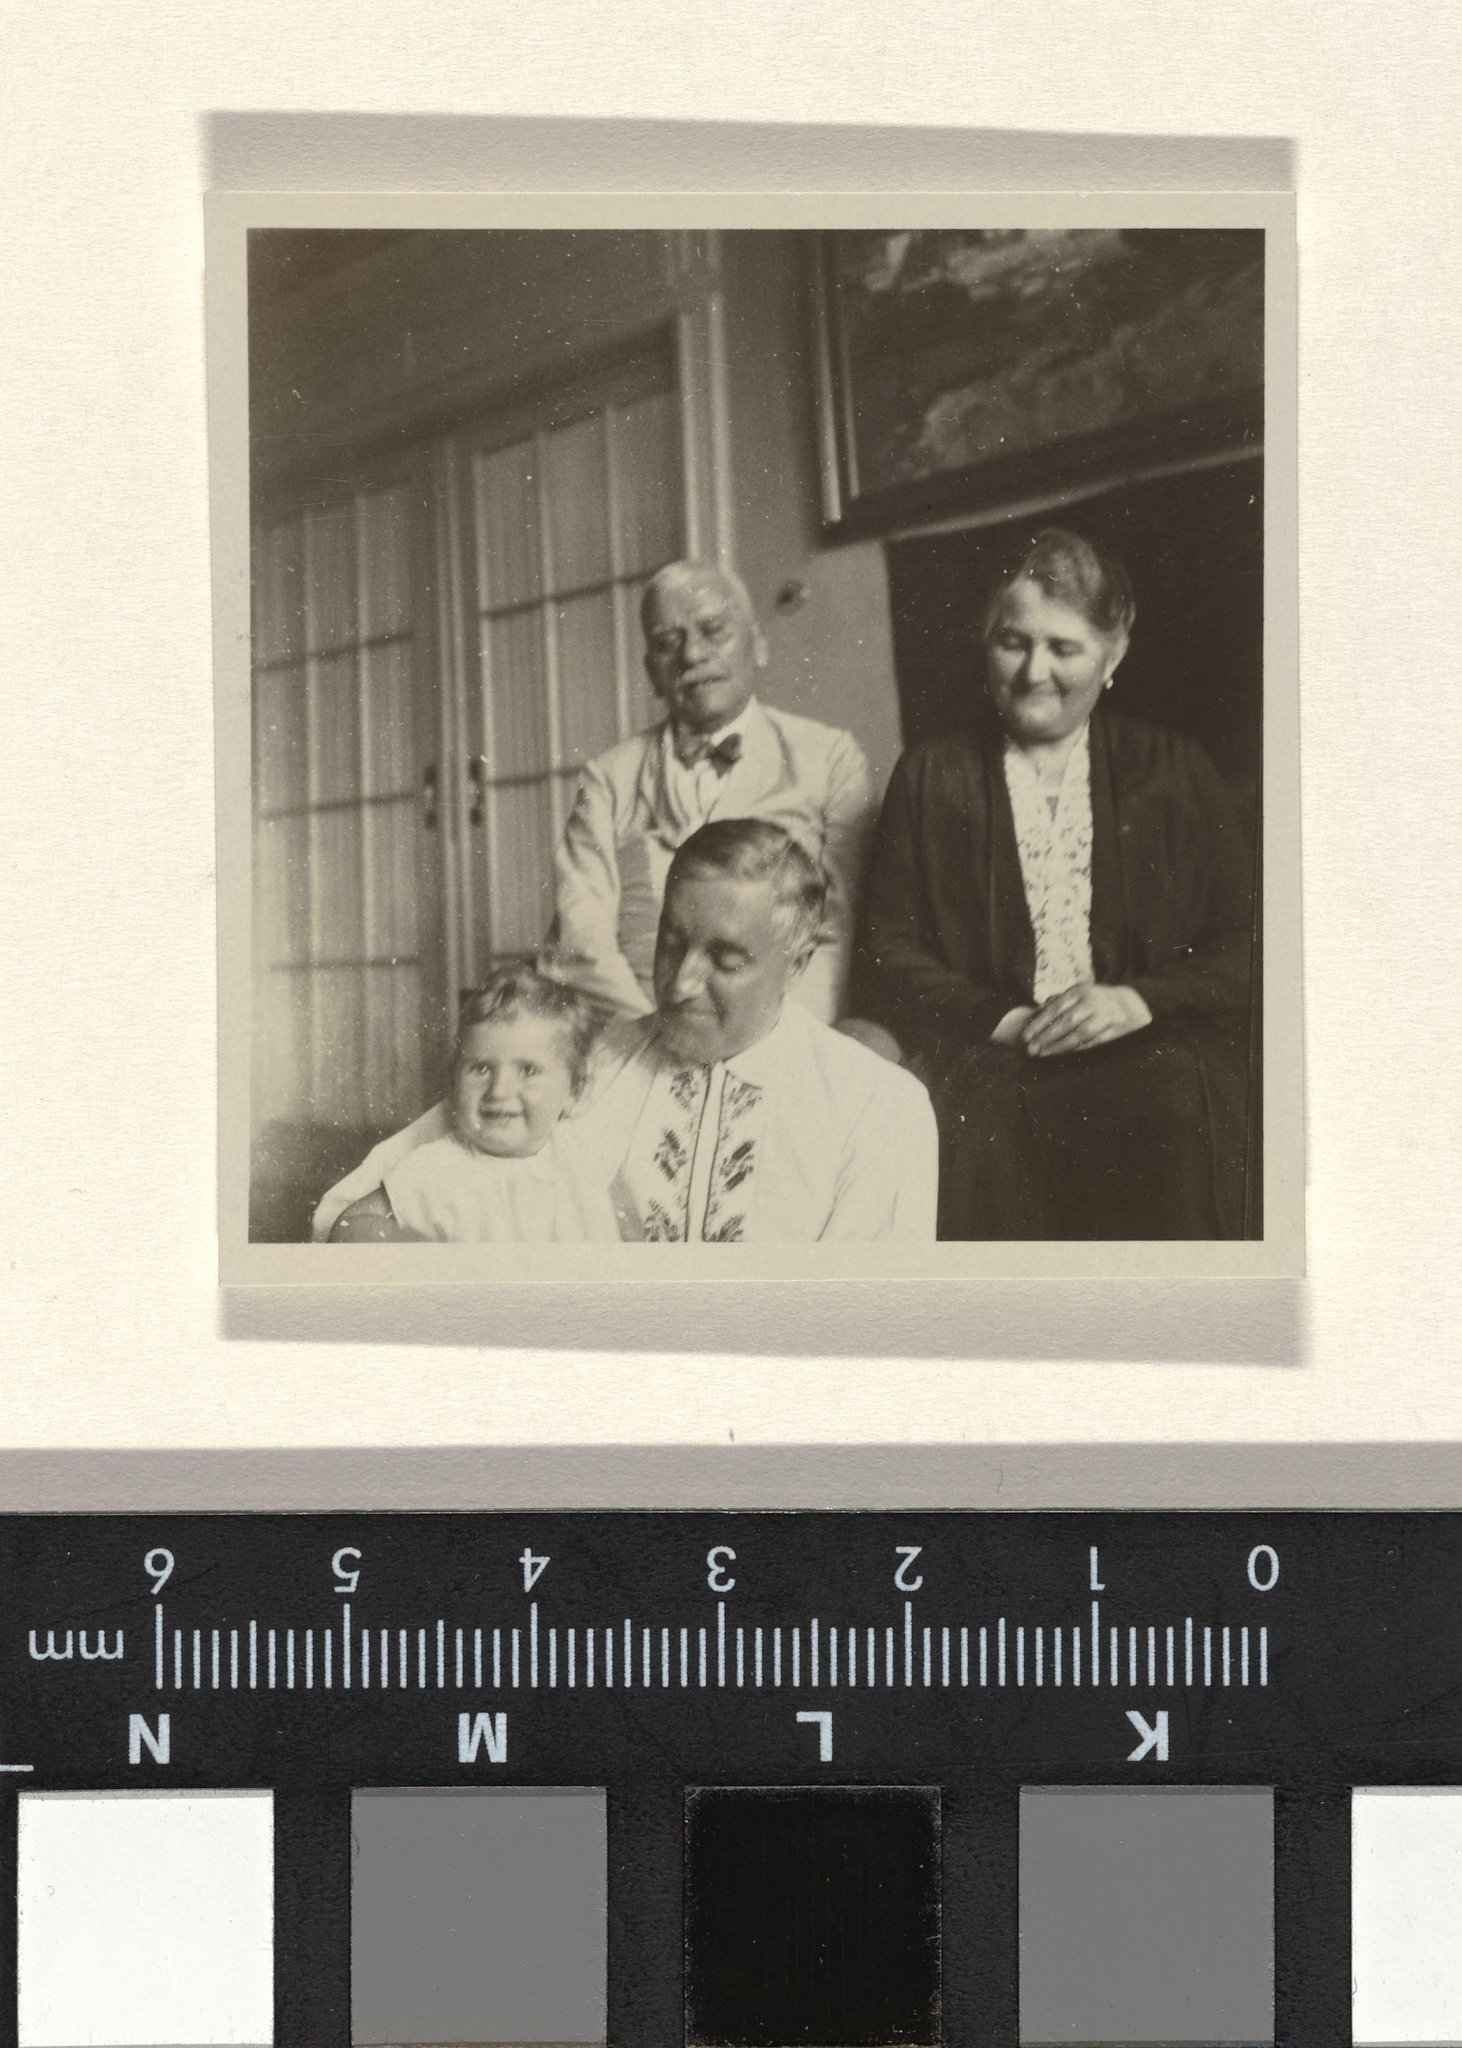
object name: photograph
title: Meir Wachenheimer, Mathilde Wachenheimer-Wertheimer, Eugen Wachenheimer, Isabel Wachenheimer in kamer, 1928-1937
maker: Anonymous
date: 1929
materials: photographic support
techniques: gelatin silver print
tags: eugen wachenheimer, leiden, isabel wachenheimer-elon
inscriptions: number: ‘67’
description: Dit object is onderdeel van de nalatenschap van Isabel Elon-Wachenheimer (1928-2010). Tot haar overlijden behoorde het samen met de andere objecten uit de nalatenschap tot haar privédomein van Isabel Wachenheimer. In die particuliere context zijn deze objecten tezamen en individueel aandenkens - aan de jeugd, ouders en familie van Isabel Wachenheimer vóór en tijdens de Shoah en aan haar leven na de Tweede Wereldoorlog. Isabel Wachenheimer, die van juni 1943 tot mei 1945 gevangen zat in Kamp Westerbork, Theresienstadt, Auschwitz, Lenzing a/d Oberdonau (een buitenkamp van Mauthausen), overleefde de Shoah. Haar ouders – Eugène Wachenheimer en Else Wachenheimer-Moos - werden op 14 oktober 1944 in Auschwitz-Birkenau vermoord.